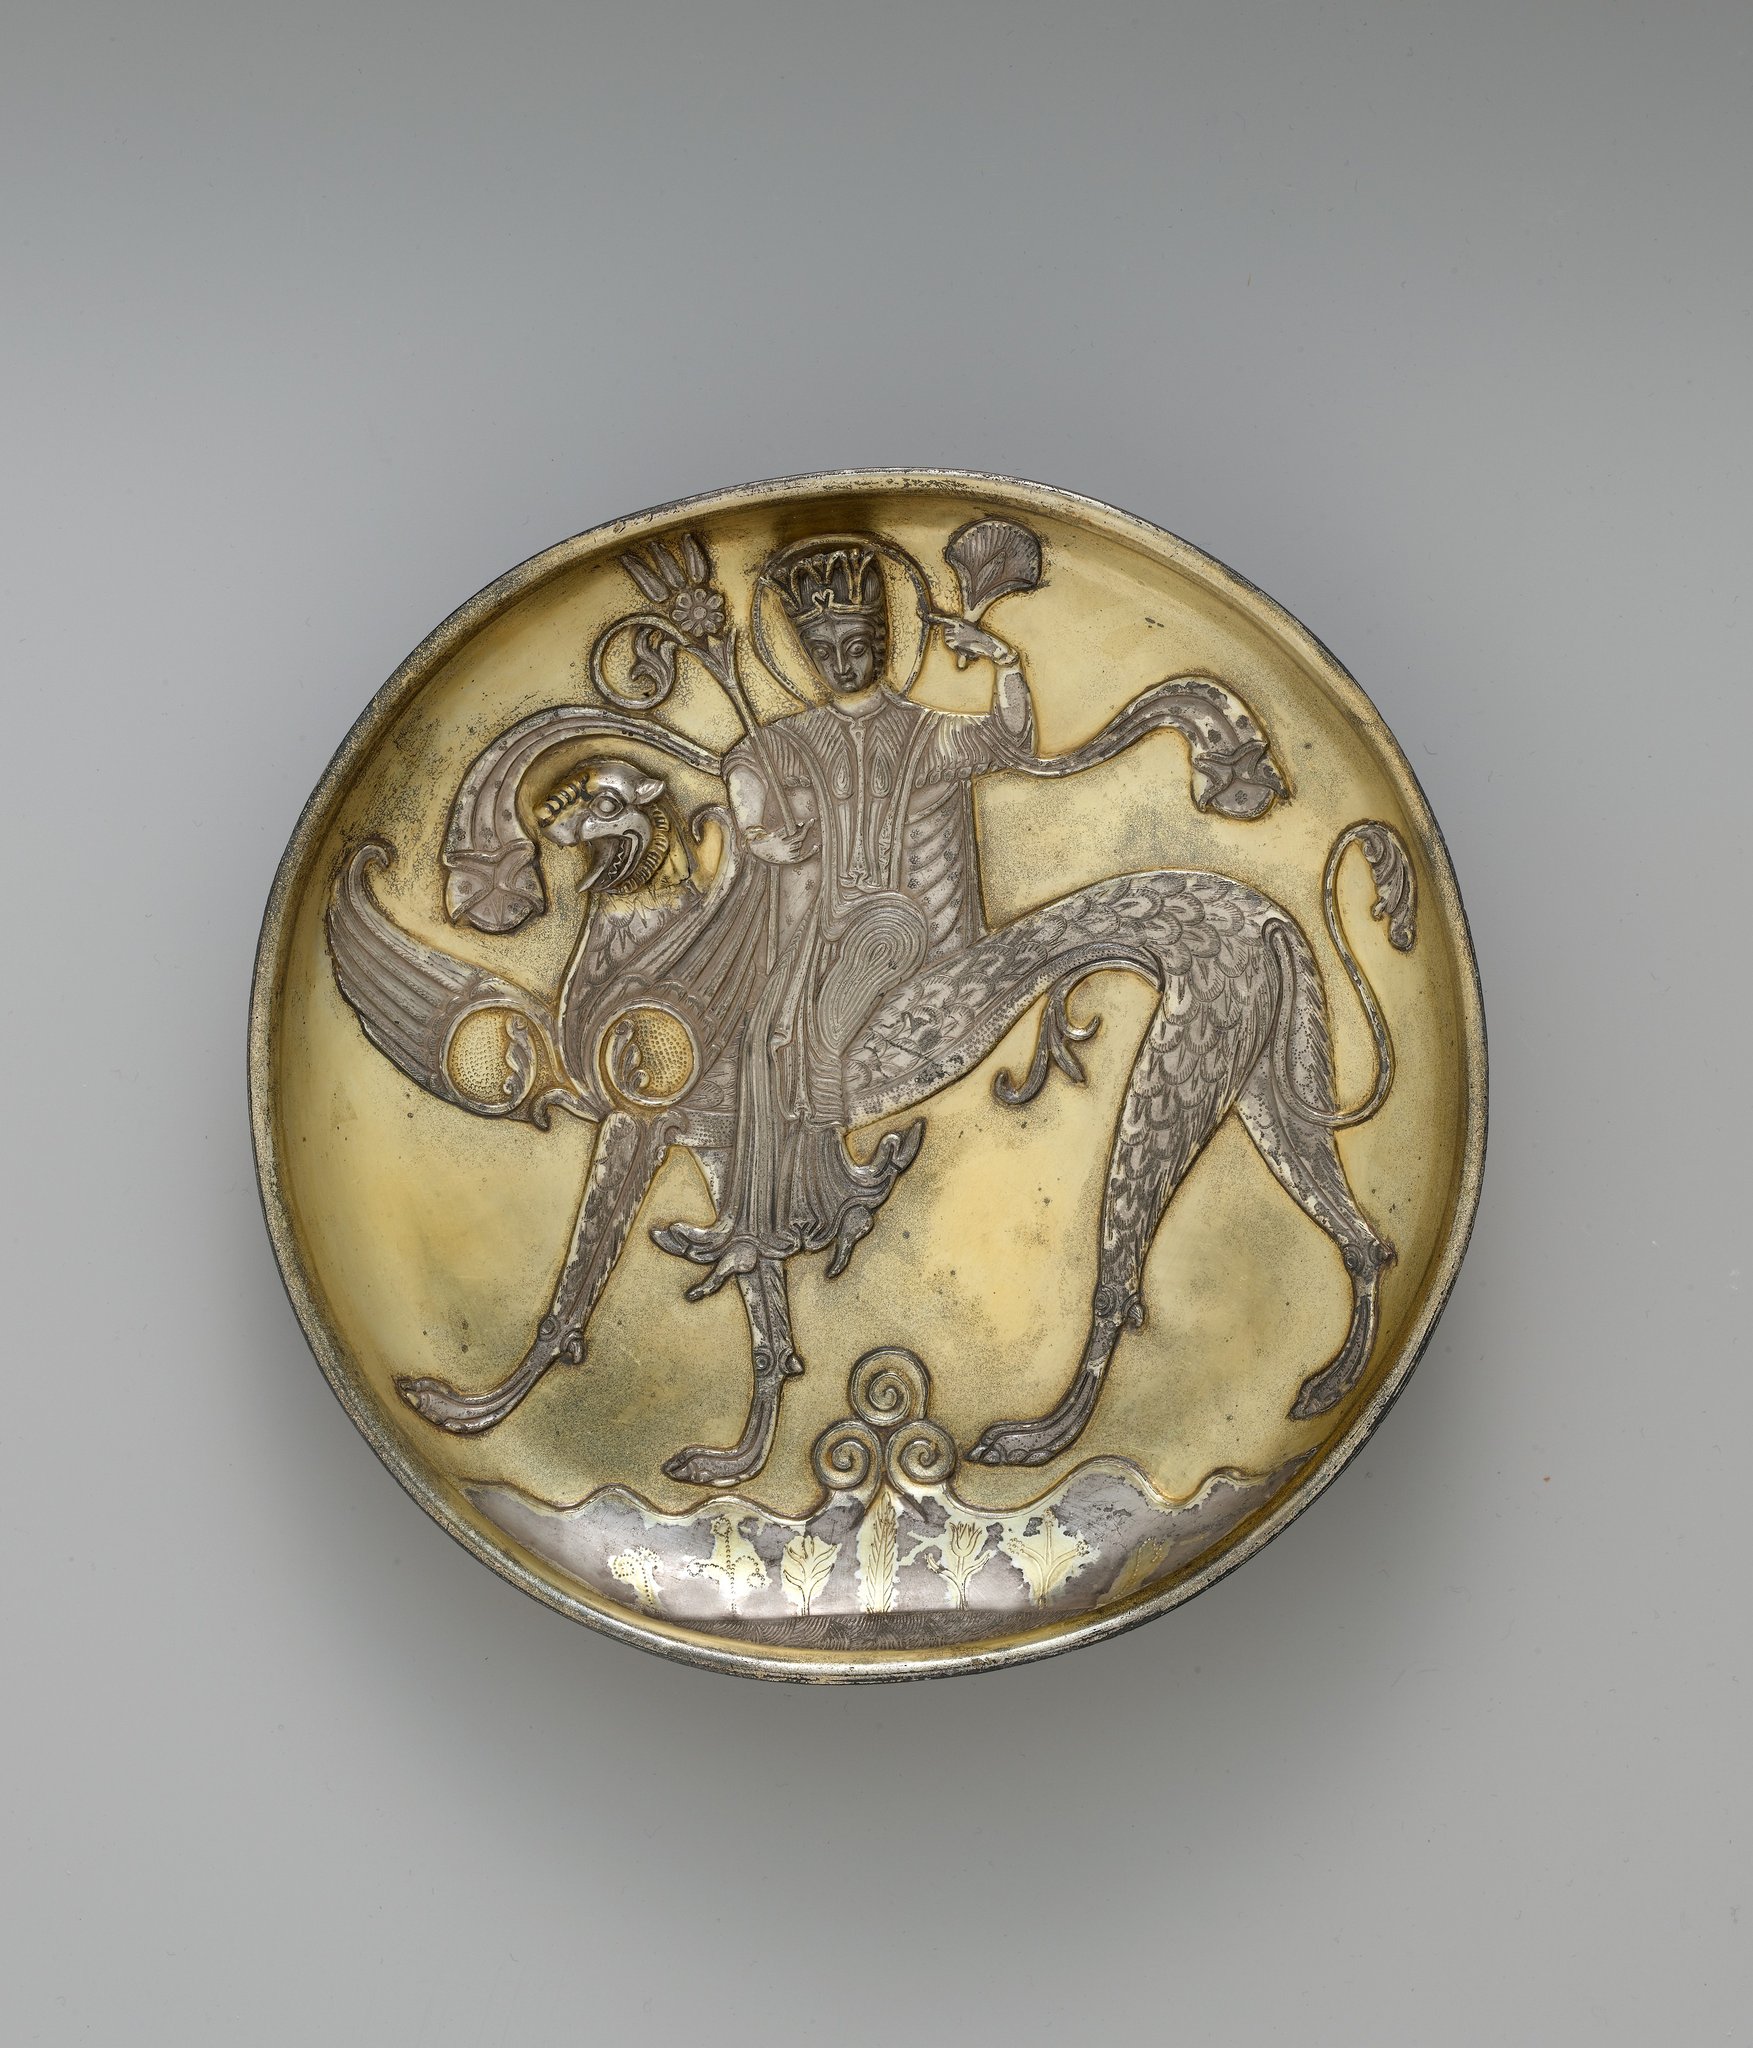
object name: plate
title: Plate Depicting a Female Figure Riding a Fantastic Winged Beast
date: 701-800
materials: silver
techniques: chasing, engraving, gilding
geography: iran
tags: women,mythical creatures